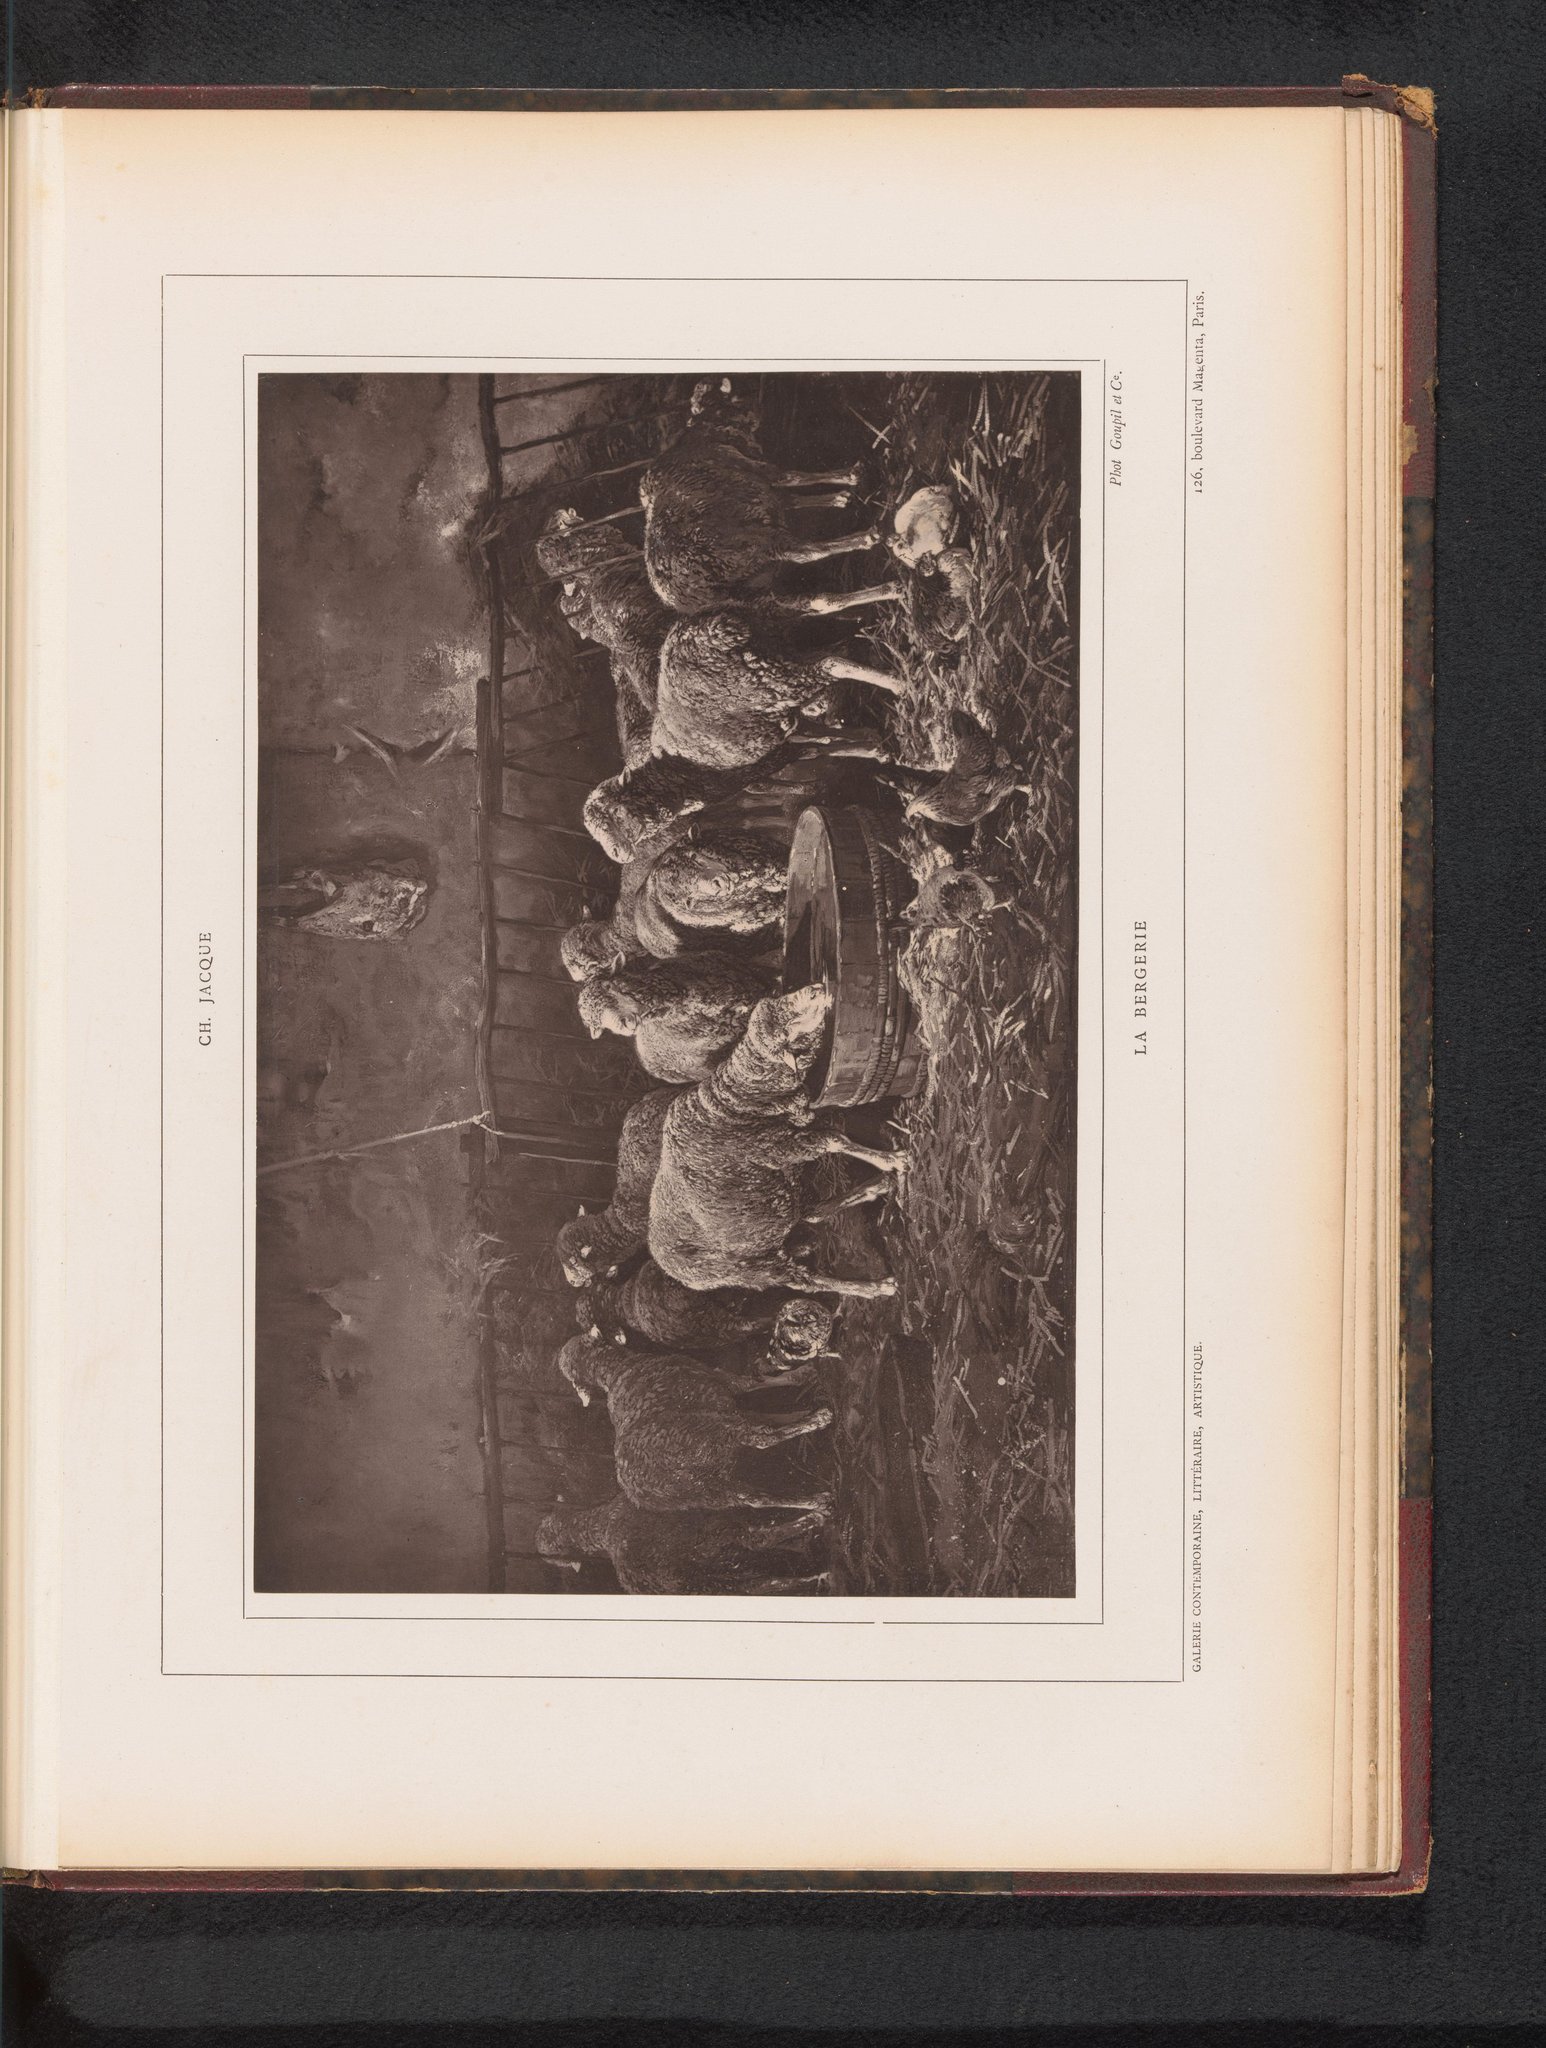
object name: reproduction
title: Reproductie van La bergerie door Charles Emile Jacque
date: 1871-1876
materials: paper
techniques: woodburytype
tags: stall, stable, herd, flock, painting, drawing and the graphic arts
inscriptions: inscription: ‘CH. Jaque/ Galerie Contemporaine, Littéraire, Artistique./ 126, boulevard Magenta, Paris.’